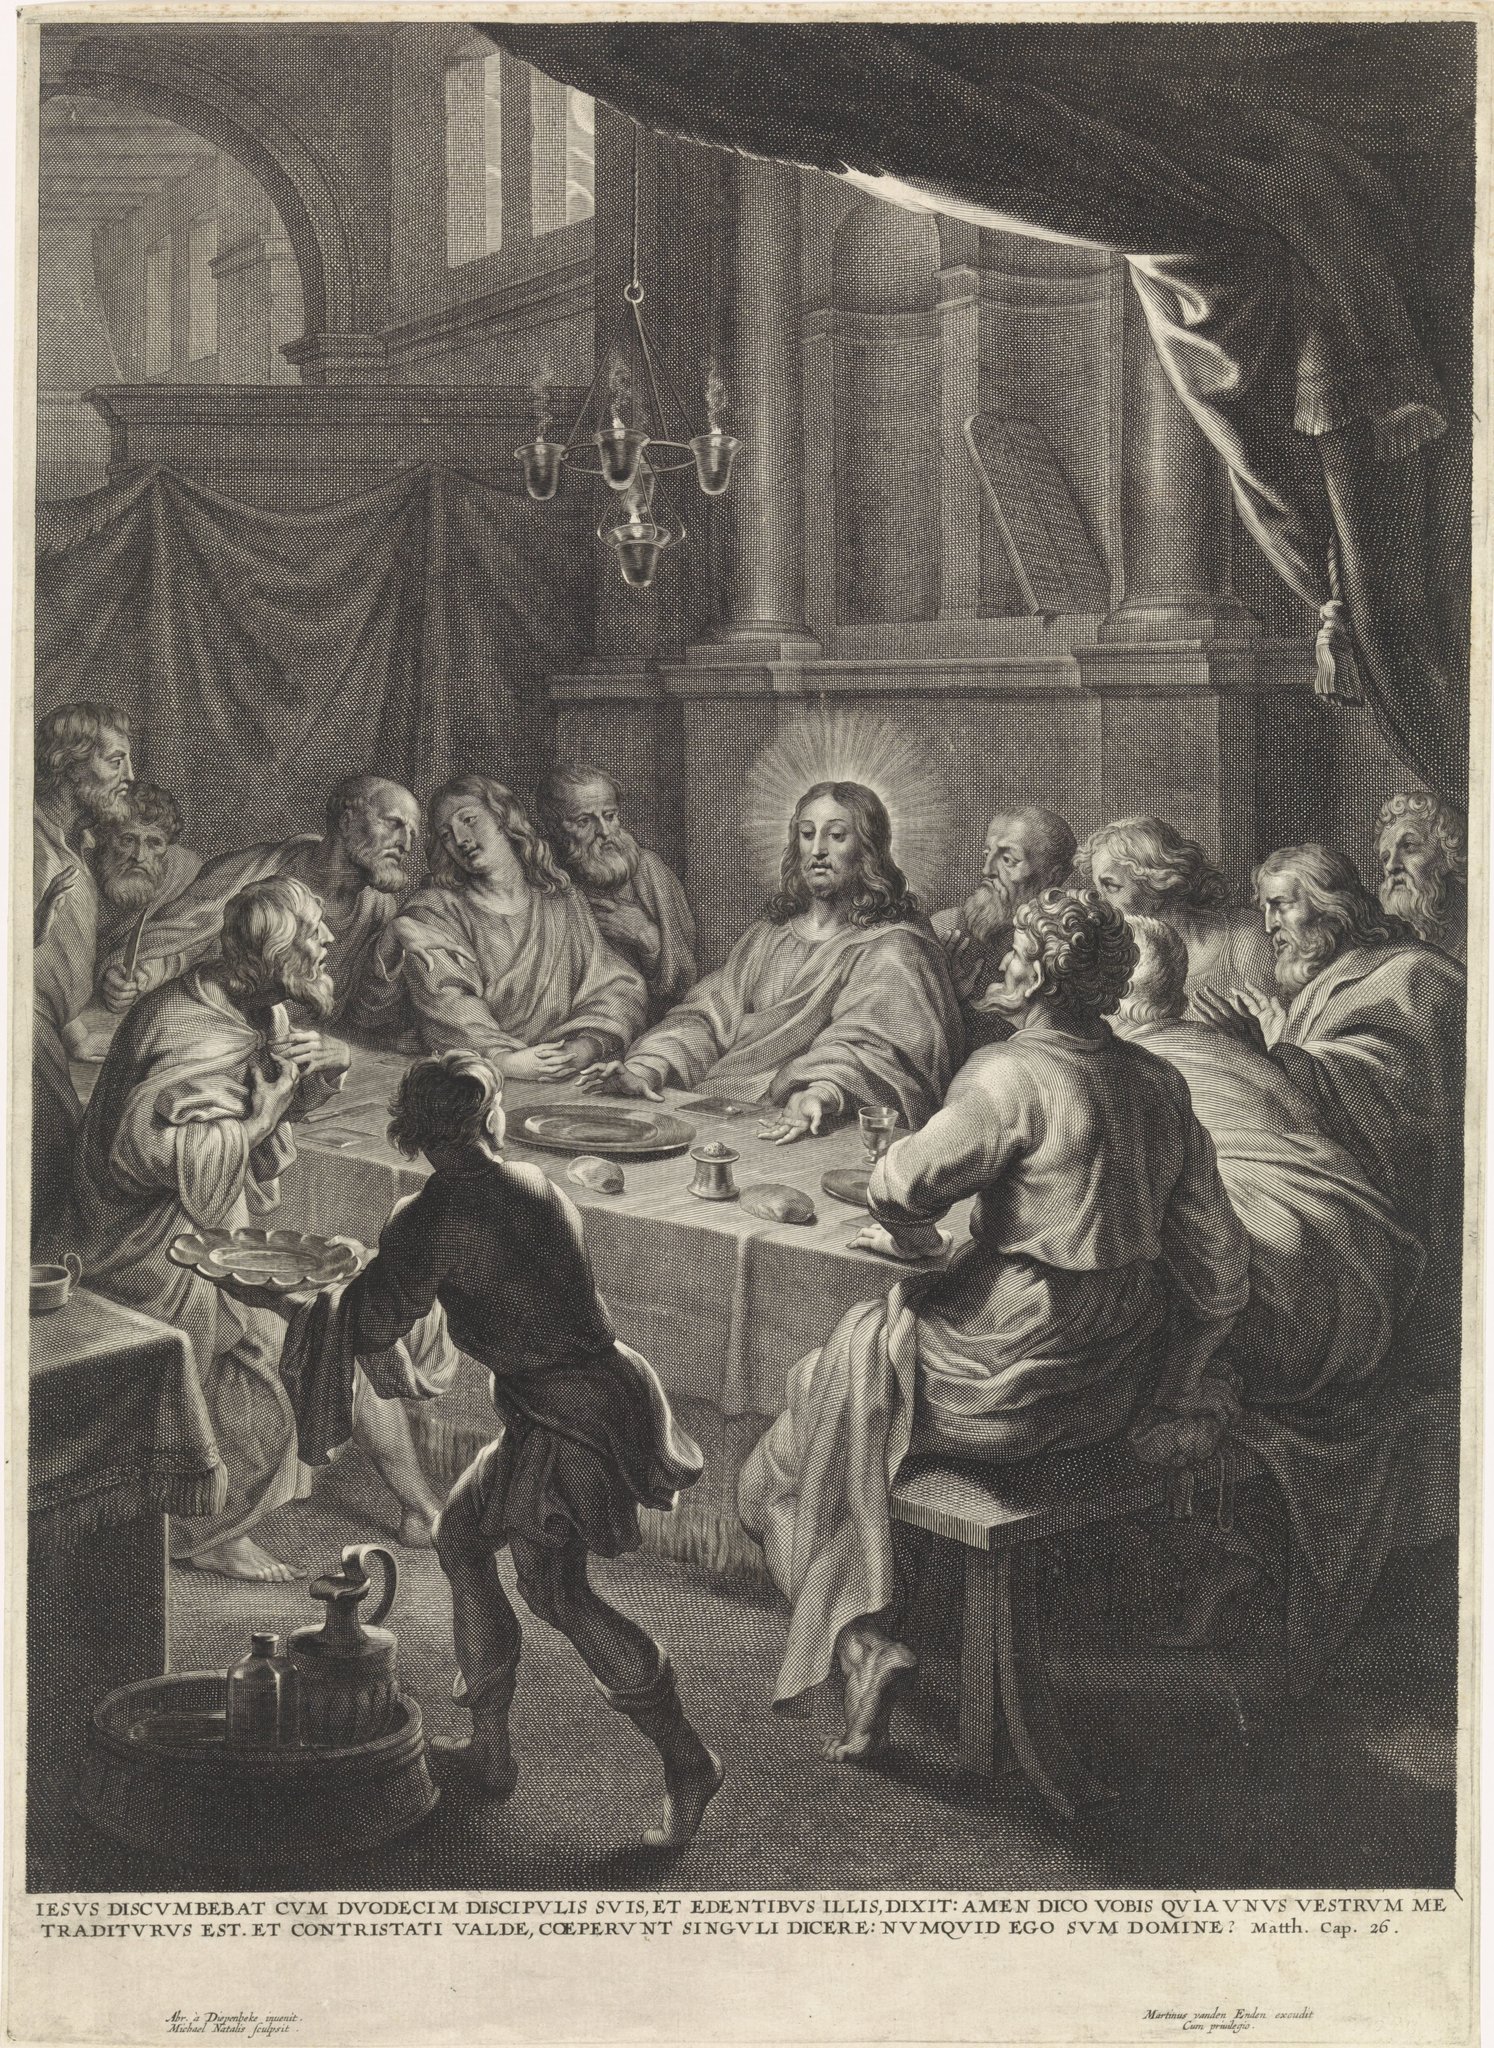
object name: print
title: Laatste Avondmaal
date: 1640-1642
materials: paper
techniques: engraving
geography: antwerp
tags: the new tables of the law (exodus 34) (+ variant), announcement of the betrayal of christ, and the reaction of the apostles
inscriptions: collector's mark: Lugt 240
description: Christus zit met de twaalf apostelen aan een lange tafel aan het Laatste Avondmaal en vertelt dat zij hem in de komende nacht zullen afvallen. Te zien is hoe de apostelen op deze boodschap reageren. Rechtsvoor op de bank zit Judas, zijn rechterhand op een zak geld. Het avondmaal vindt plaats in het interieur van een kerk. Boven Christus staan in een nis de stenen wetstafelen van Mozes. Voorstelling naar Mat. 26: 31-35. Onderaan in de marge een tweeregelige tekst in het Latijn.